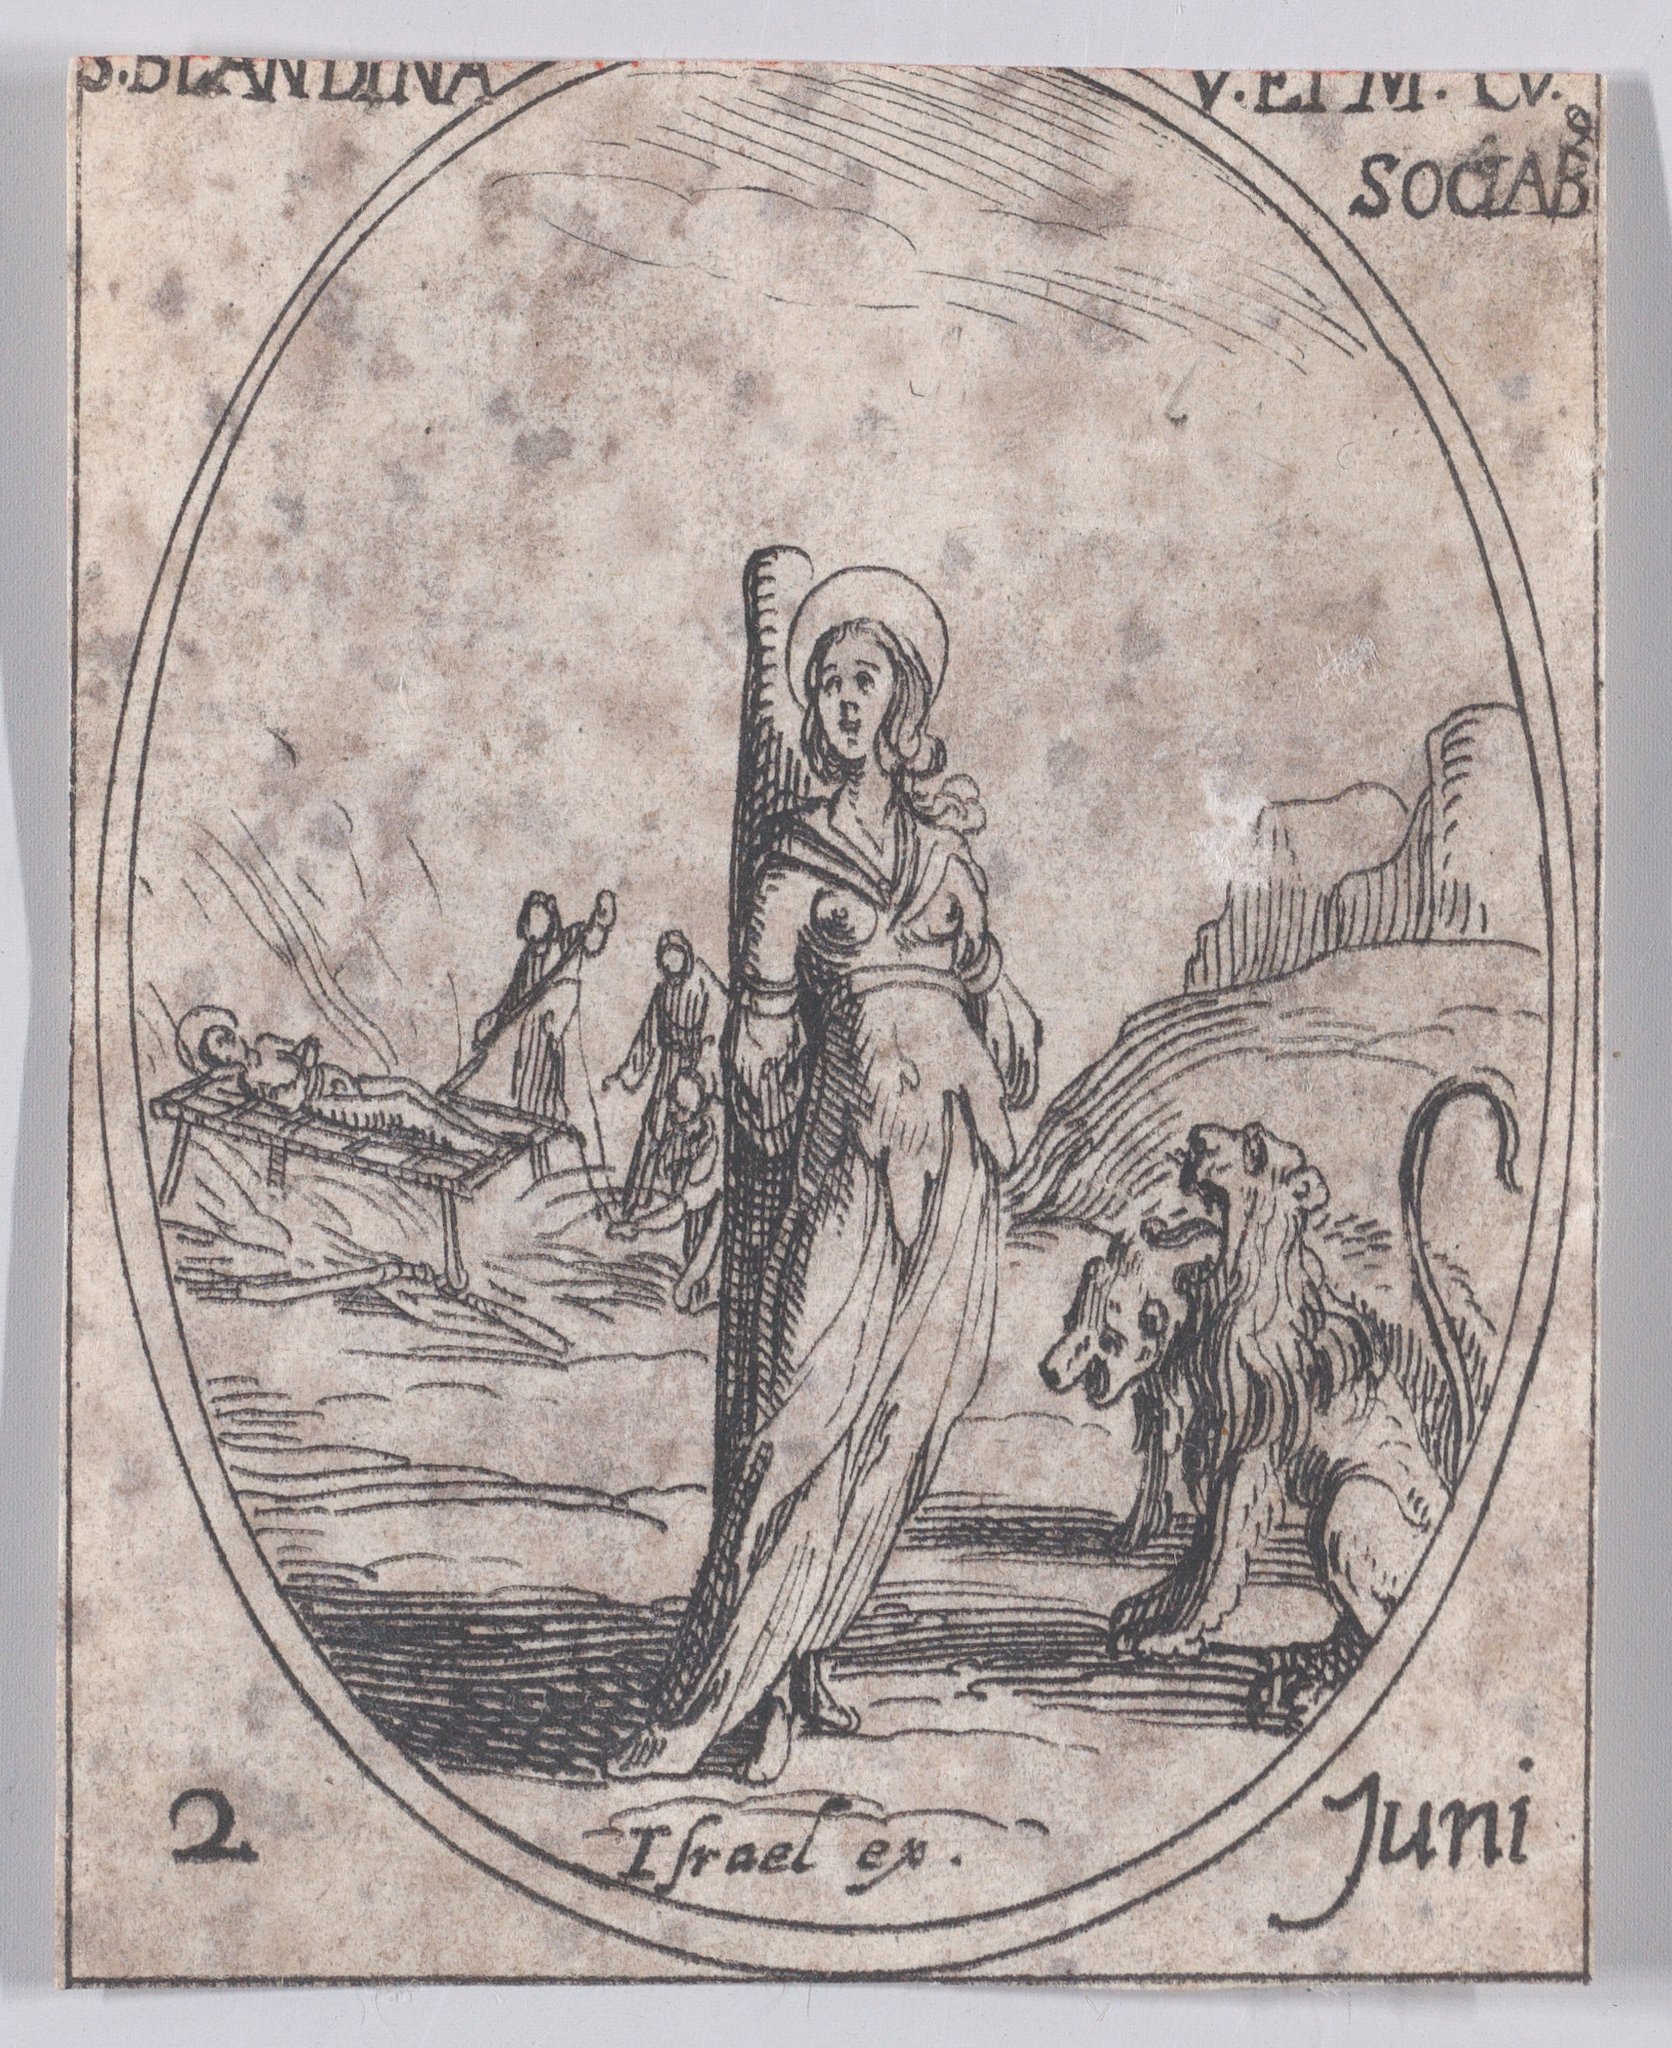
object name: print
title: Ste. Blandine et Ses Compagnes (St. Blandina and Her Companions), June 2nd, from "Les Images De Tous Les Saincts et Saintes de L'Année" (Images of All of the Saints and Religious Events of the Year)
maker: jacques callot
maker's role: artist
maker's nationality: french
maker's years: 1592-1635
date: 1636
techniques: etching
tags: animals,women,saints